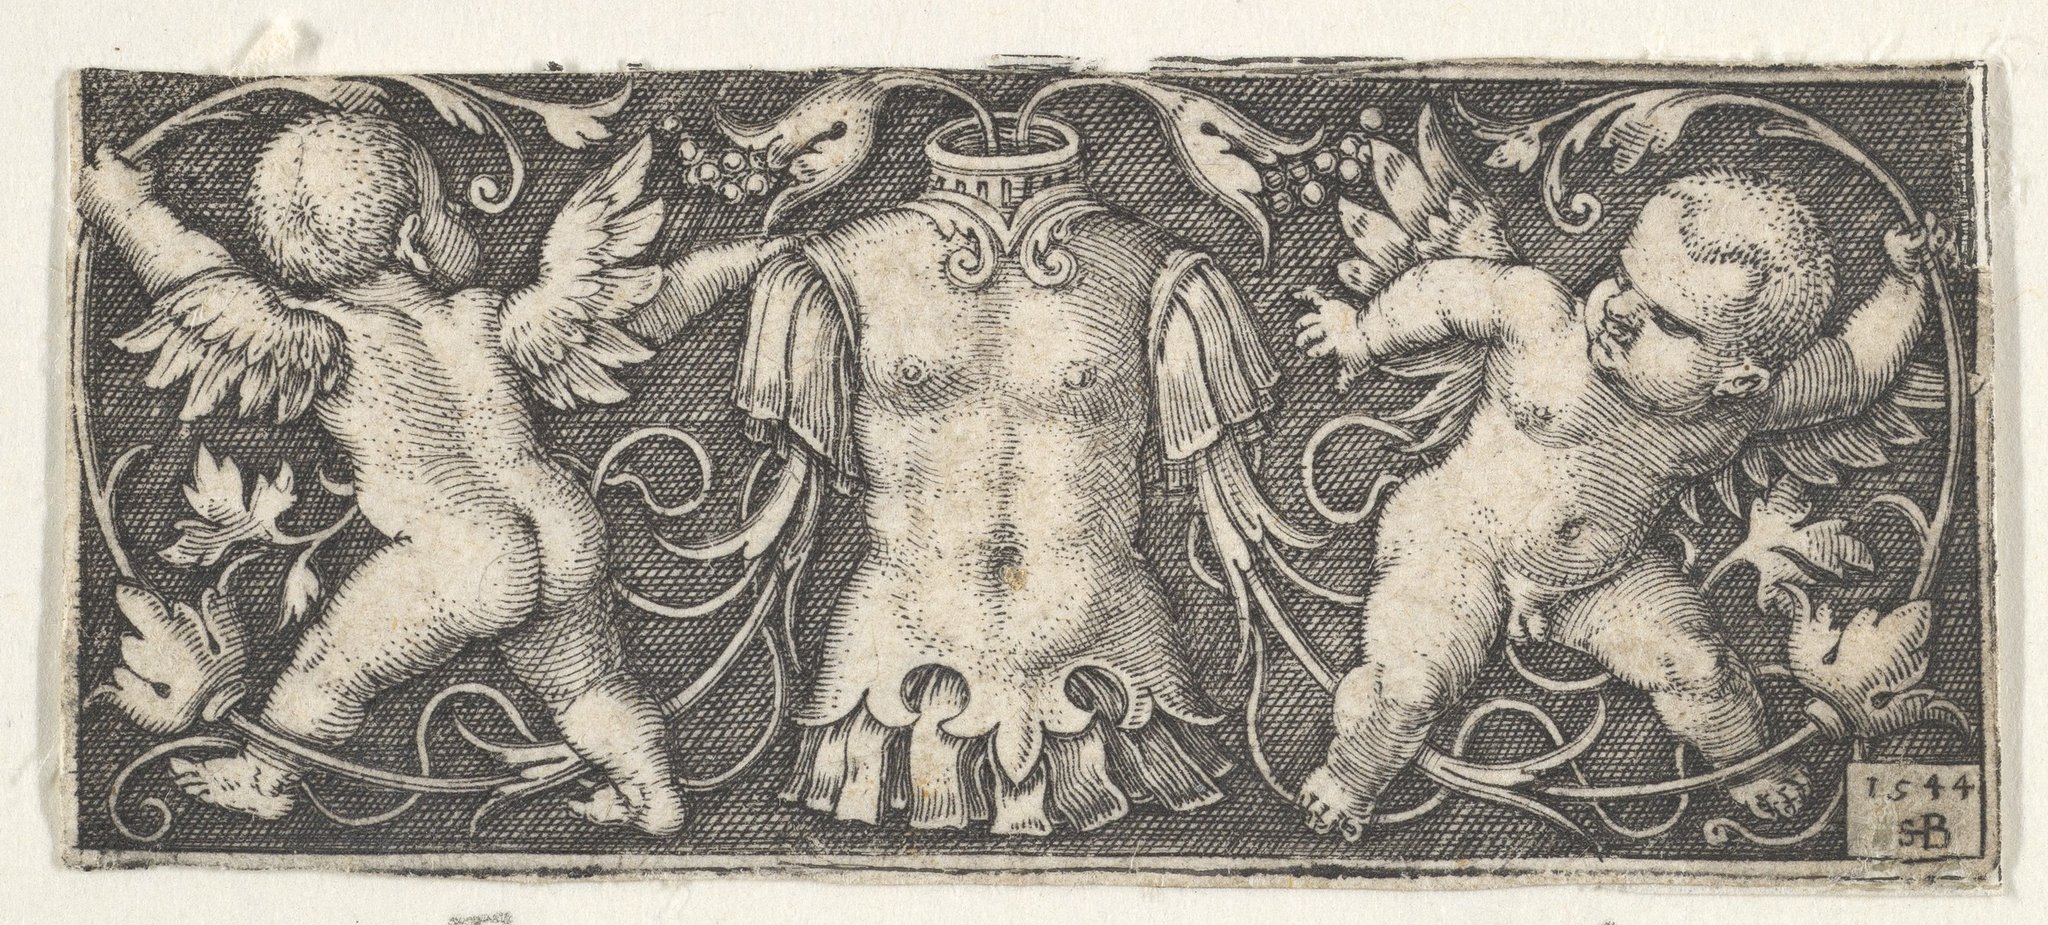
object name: print ornament architecture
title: Horizontal Panel with Armor at Center, Flanked by Two Genii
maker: sebald beham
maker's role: artist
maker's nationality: german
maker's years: 1500-1550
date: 1544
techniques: engraving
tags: armor,putti